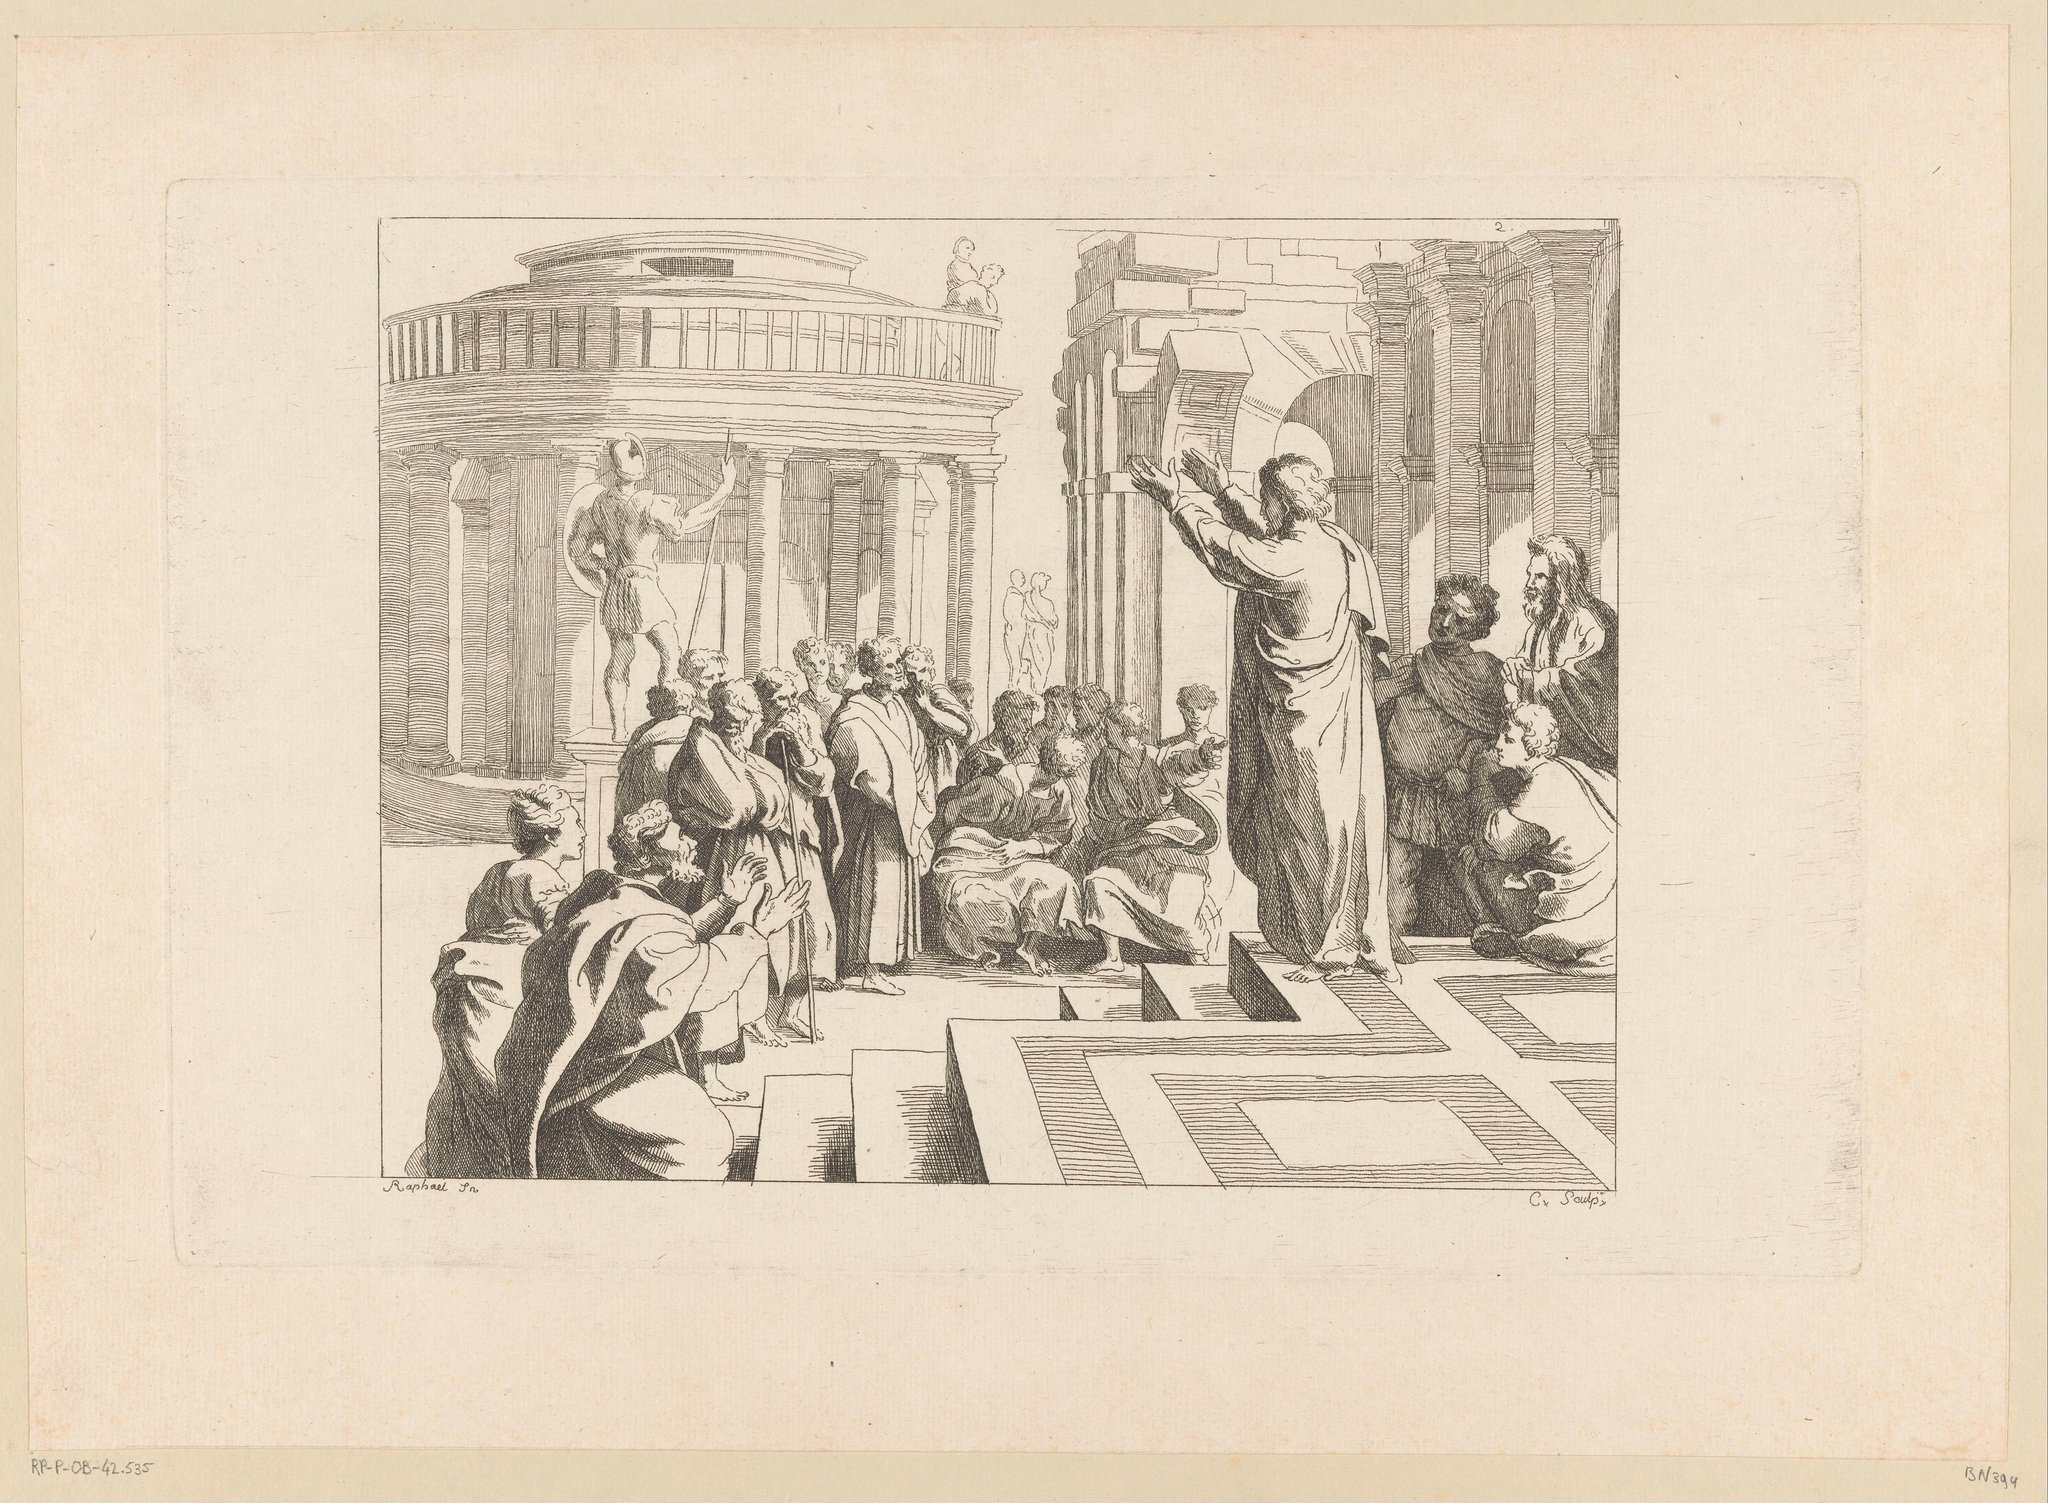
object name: print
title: Prediking van Paulus in Athene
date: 1702-1765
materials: paper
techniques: etching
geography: france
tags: paul in athens: on the areopagus he discusses with philosophers (in front of the temple of mars), temple, shrine ~ roman religion, paul preaching or disputing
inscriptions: collector's mark: Lugt 240